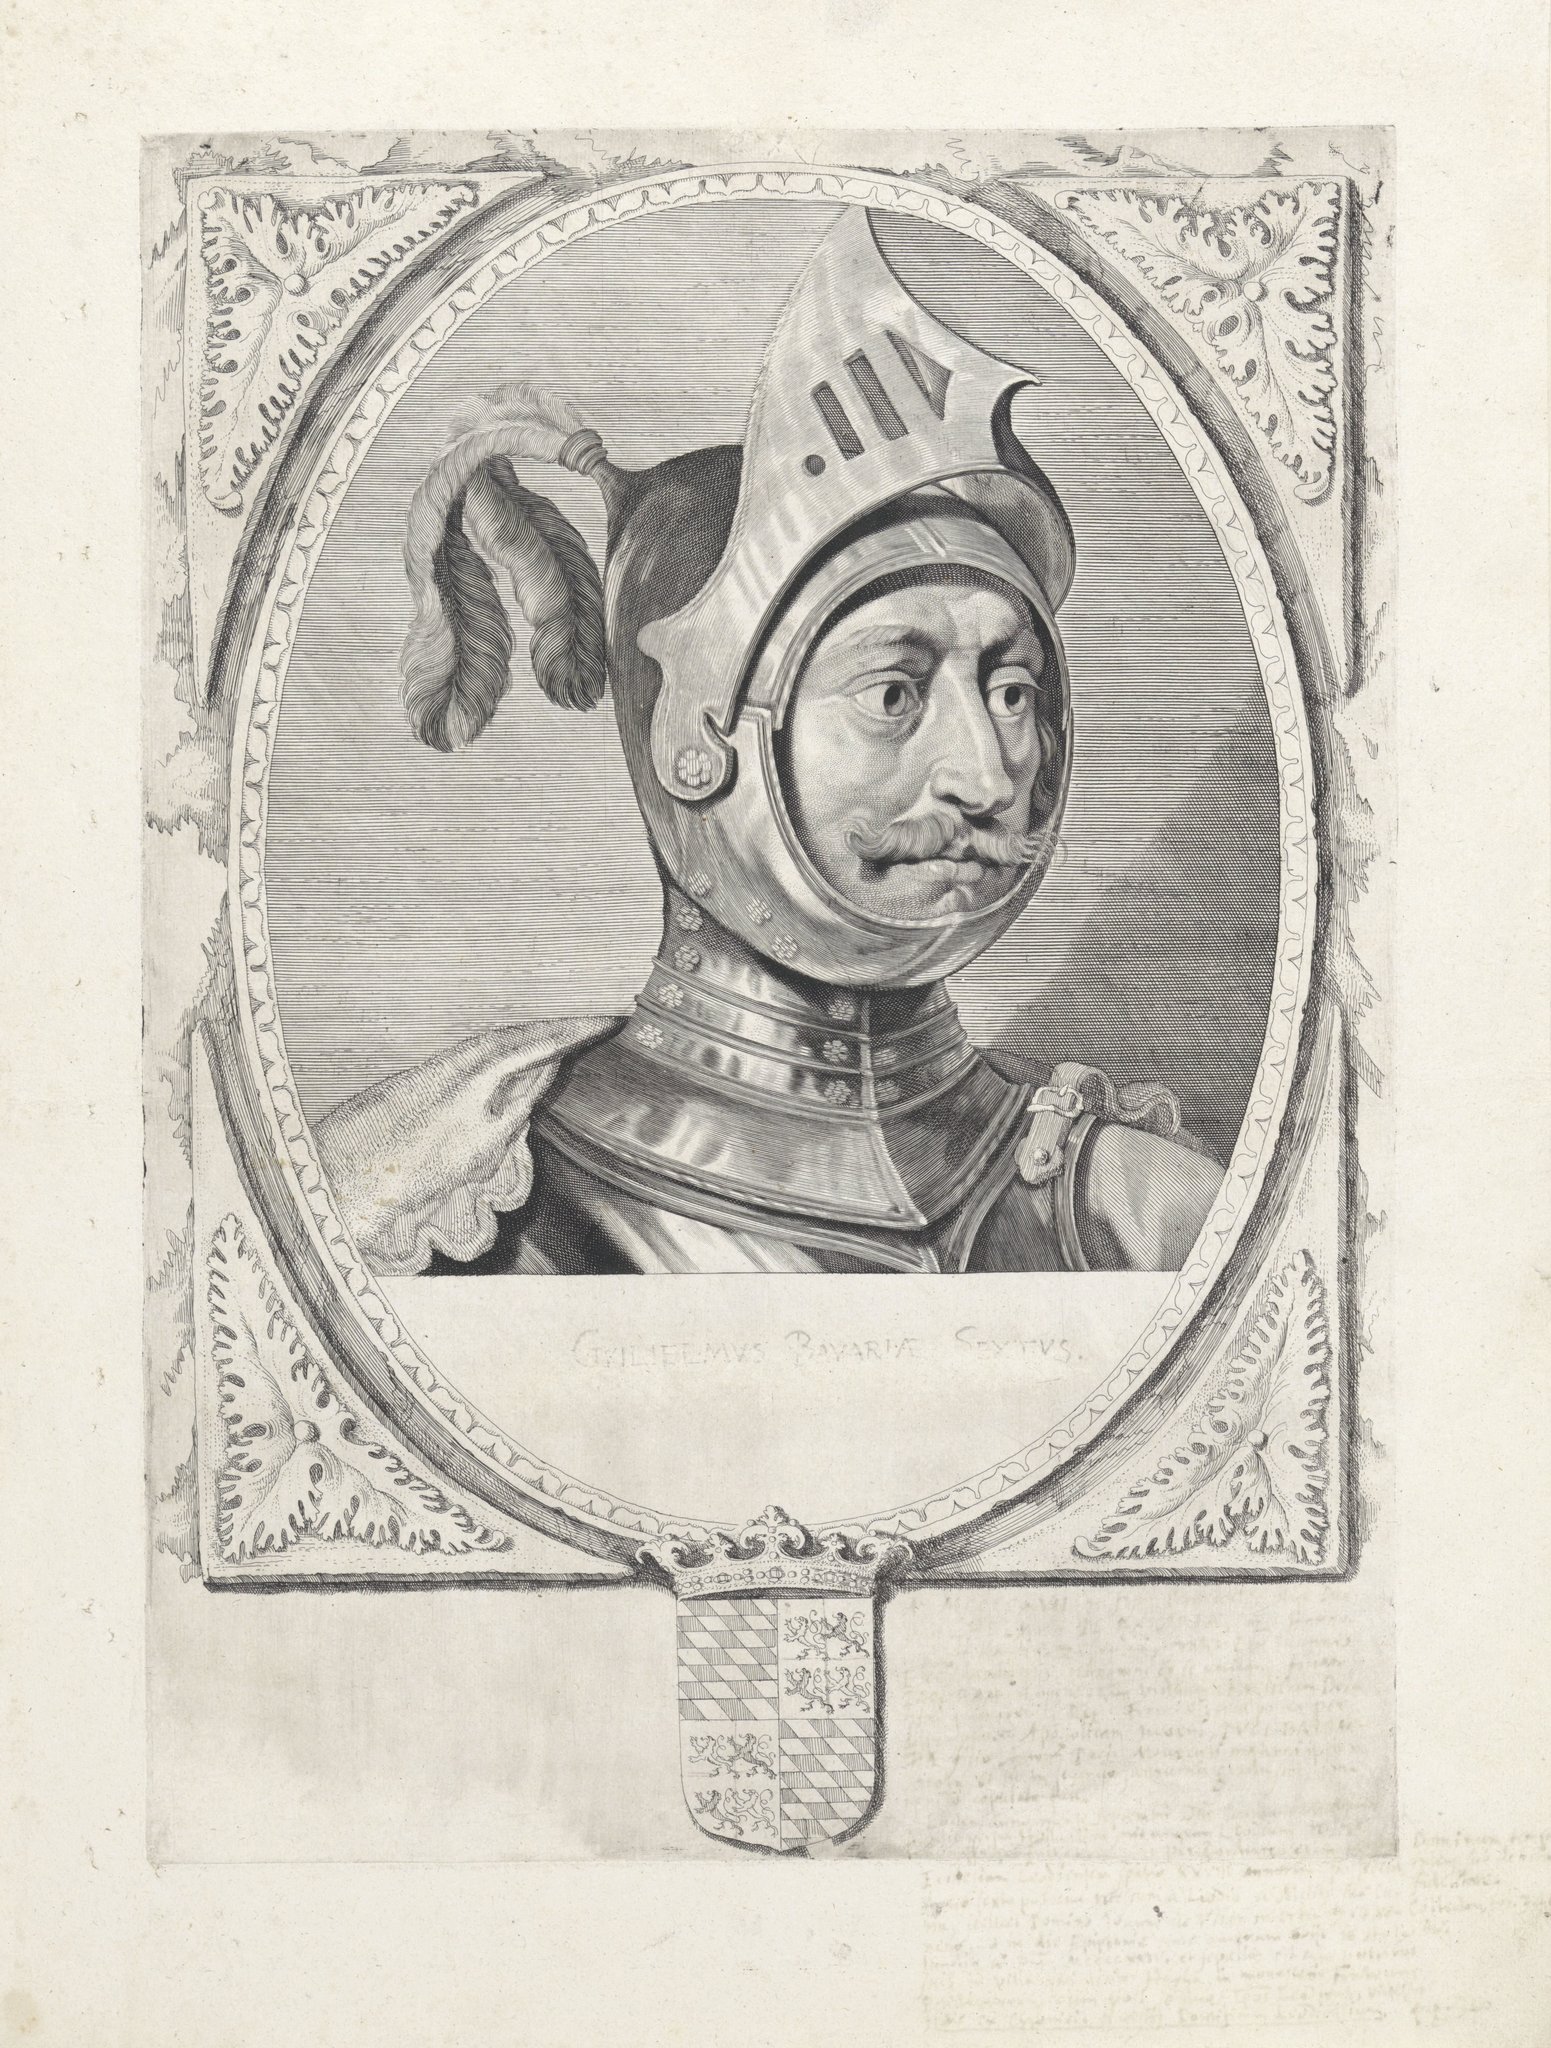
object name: print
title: Portret van Willem VI van Henegouwen, Holland en Zeeland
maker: cornelis visscher (ii)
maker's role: draughtsman, painter, print maker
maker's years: 1628-1658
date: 1650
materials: paper, pencil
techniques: etching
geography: haarlem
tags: holland en zeeland willem vi van henegouwen, helmet, armour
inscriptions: collector's mark: Lugt 240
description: Proefdruk van de zevenentwintigste prent uit de serie 'Graven en gravinnen van Holland, Zeeland en West-Friesland', bestaande uit 38 prenten.